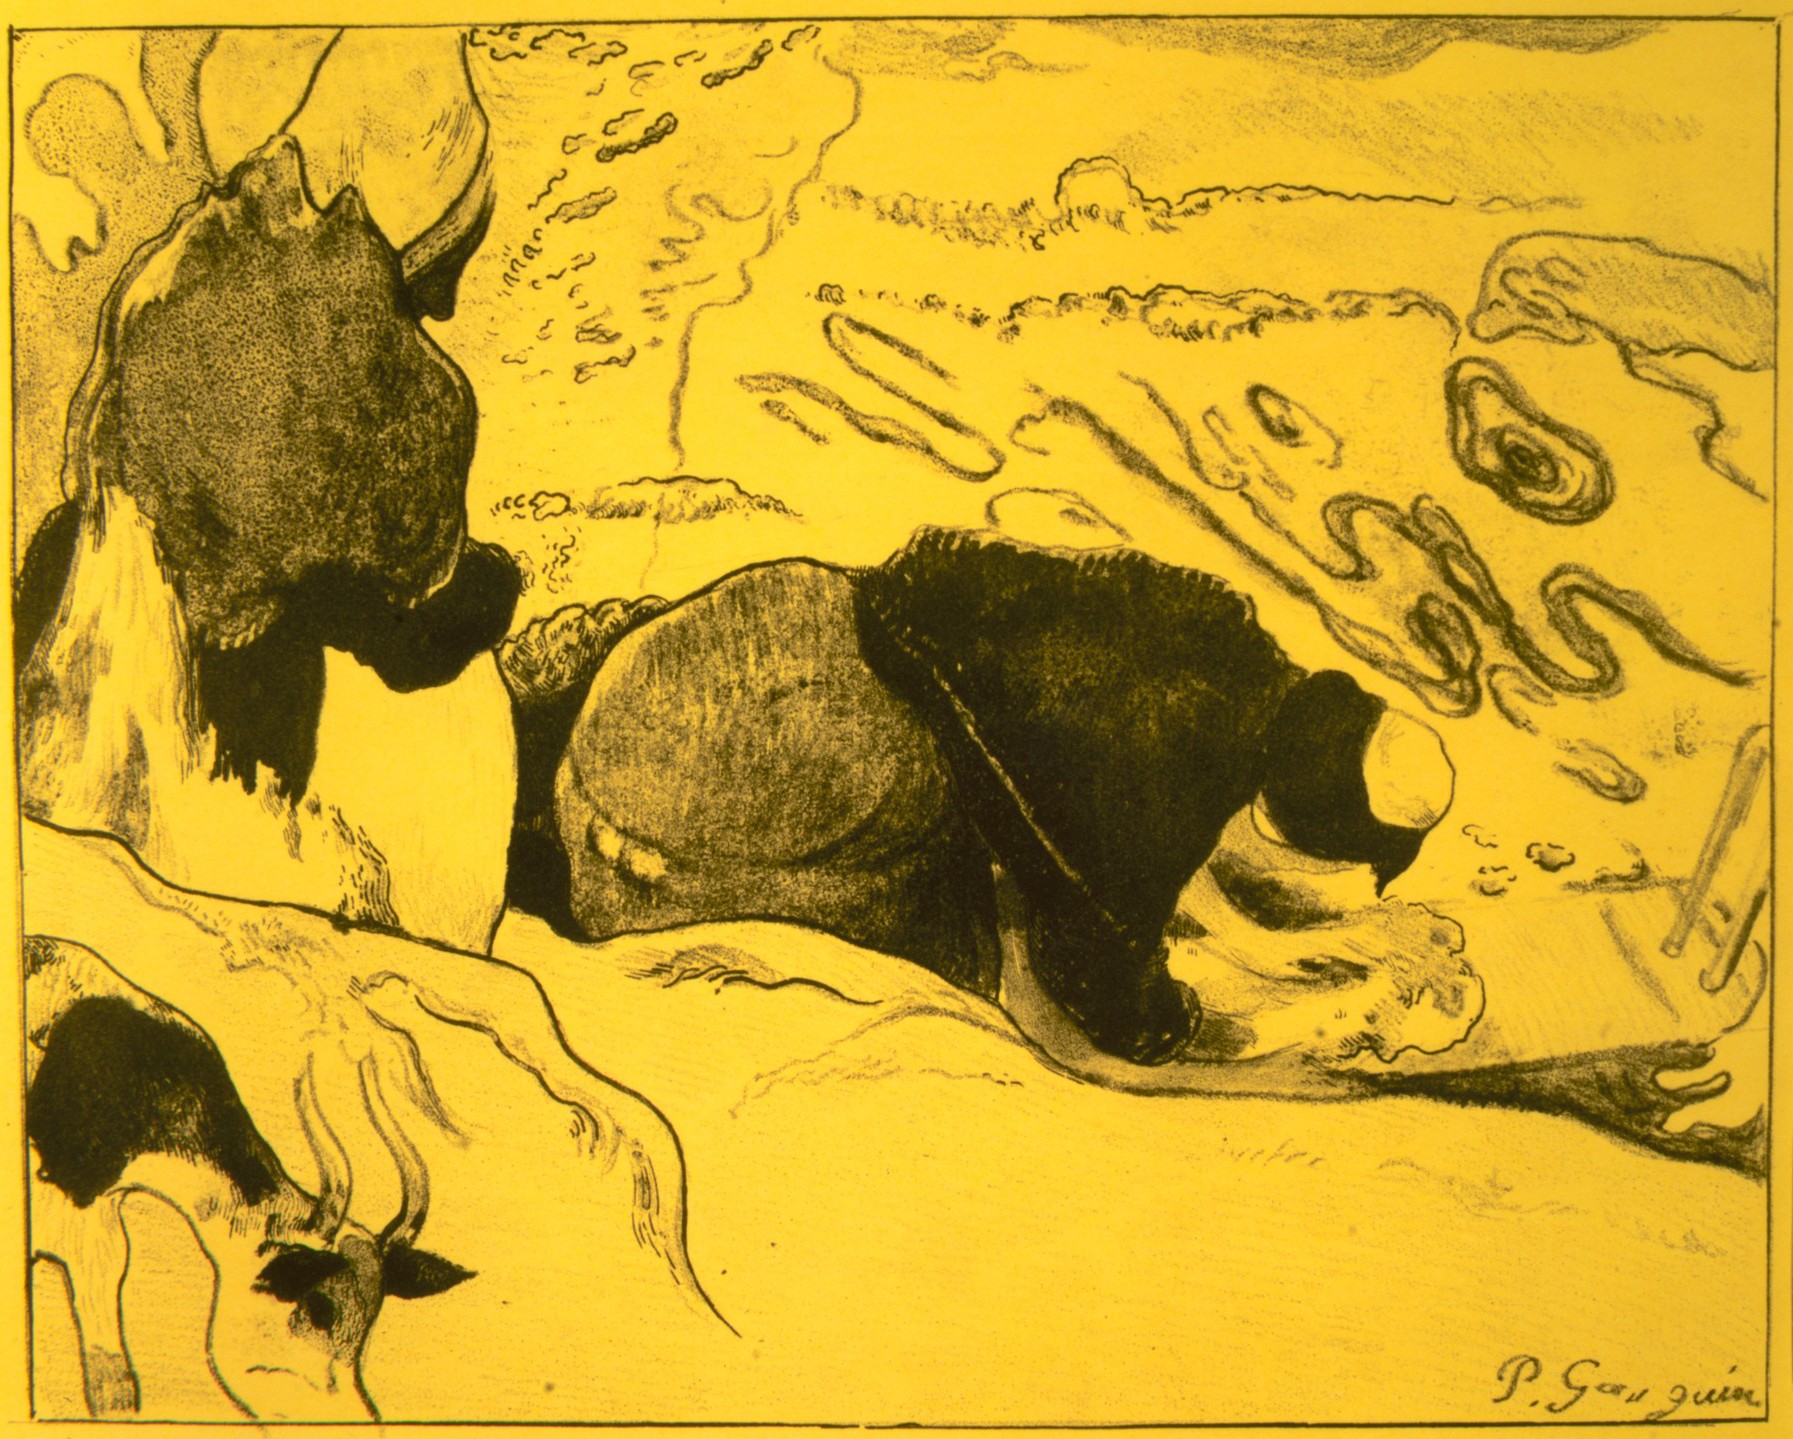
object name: print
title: Washerwomen, from the "Volpini Suite: Dessins lithographiques"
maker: paul gauguin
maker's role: artist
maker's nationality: french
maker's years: 1848-1903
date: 1889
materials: paper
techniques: lithography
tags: human figures,animals